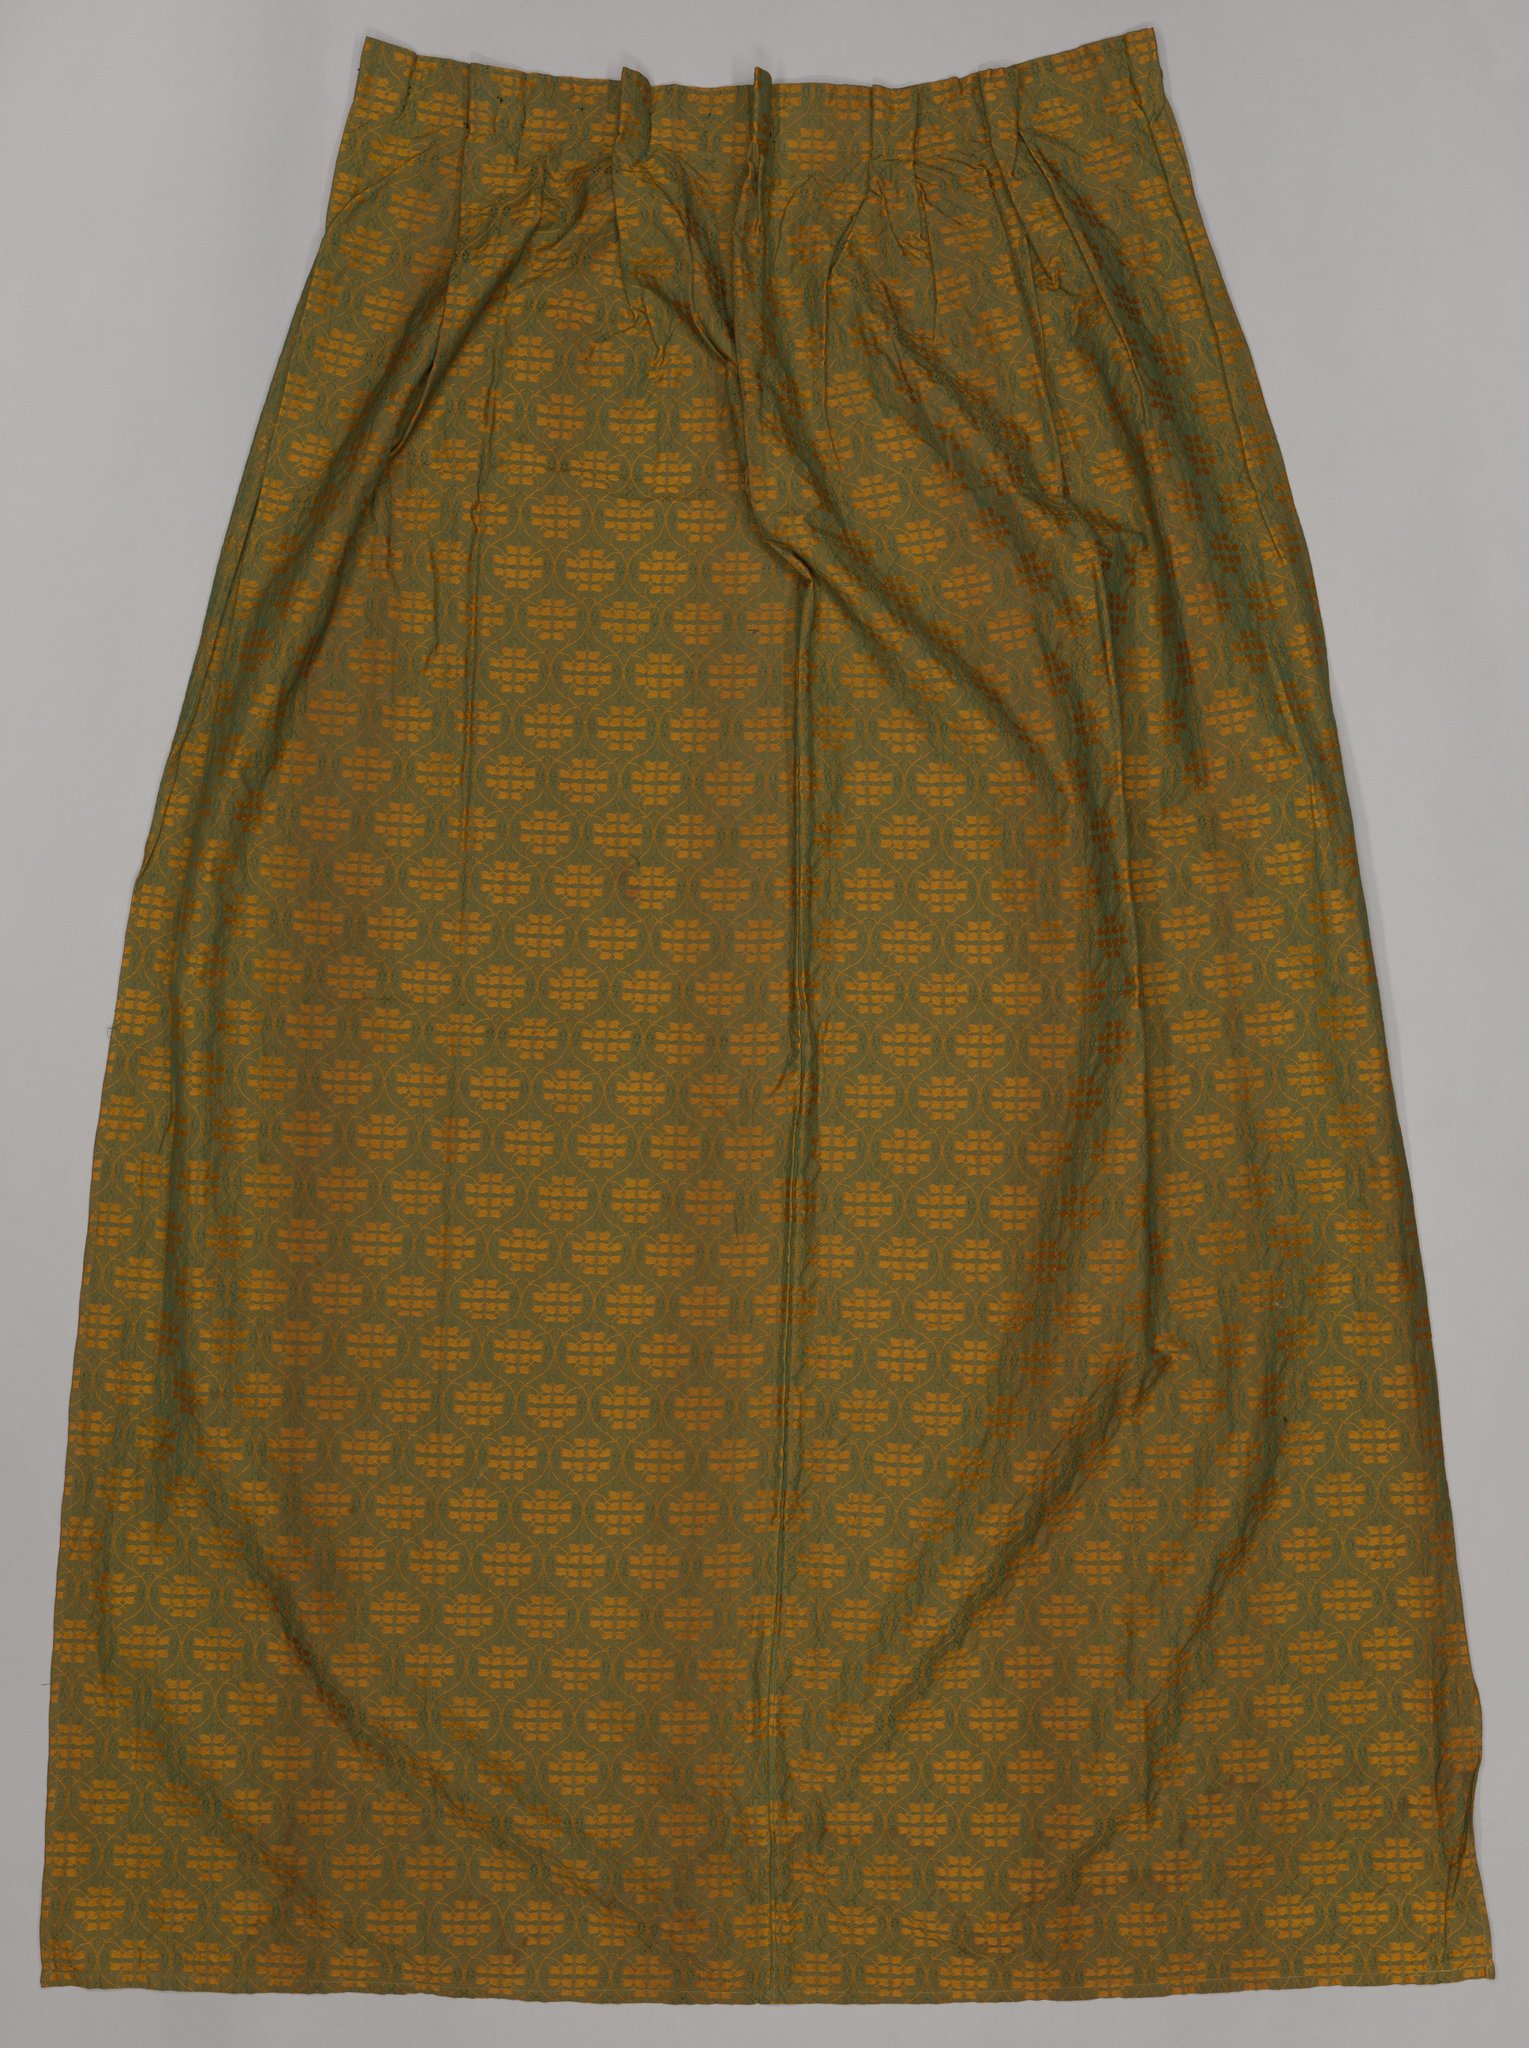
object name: curtain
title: Gordijn met patroon van bladeren binnen spitsovalen in geel op groene fond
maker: theo nieuwenhuis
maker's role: designer, draughtsman, print maker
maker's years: 1866-1951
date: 1909-1924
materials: cotton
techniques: jacquard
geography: helmond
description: Gordijn van jacquardweefsel met zich herhalend motief van bladeren binnen spitsovalen. Gele inslag op groene ketting. Voorzien van metalen ringen.